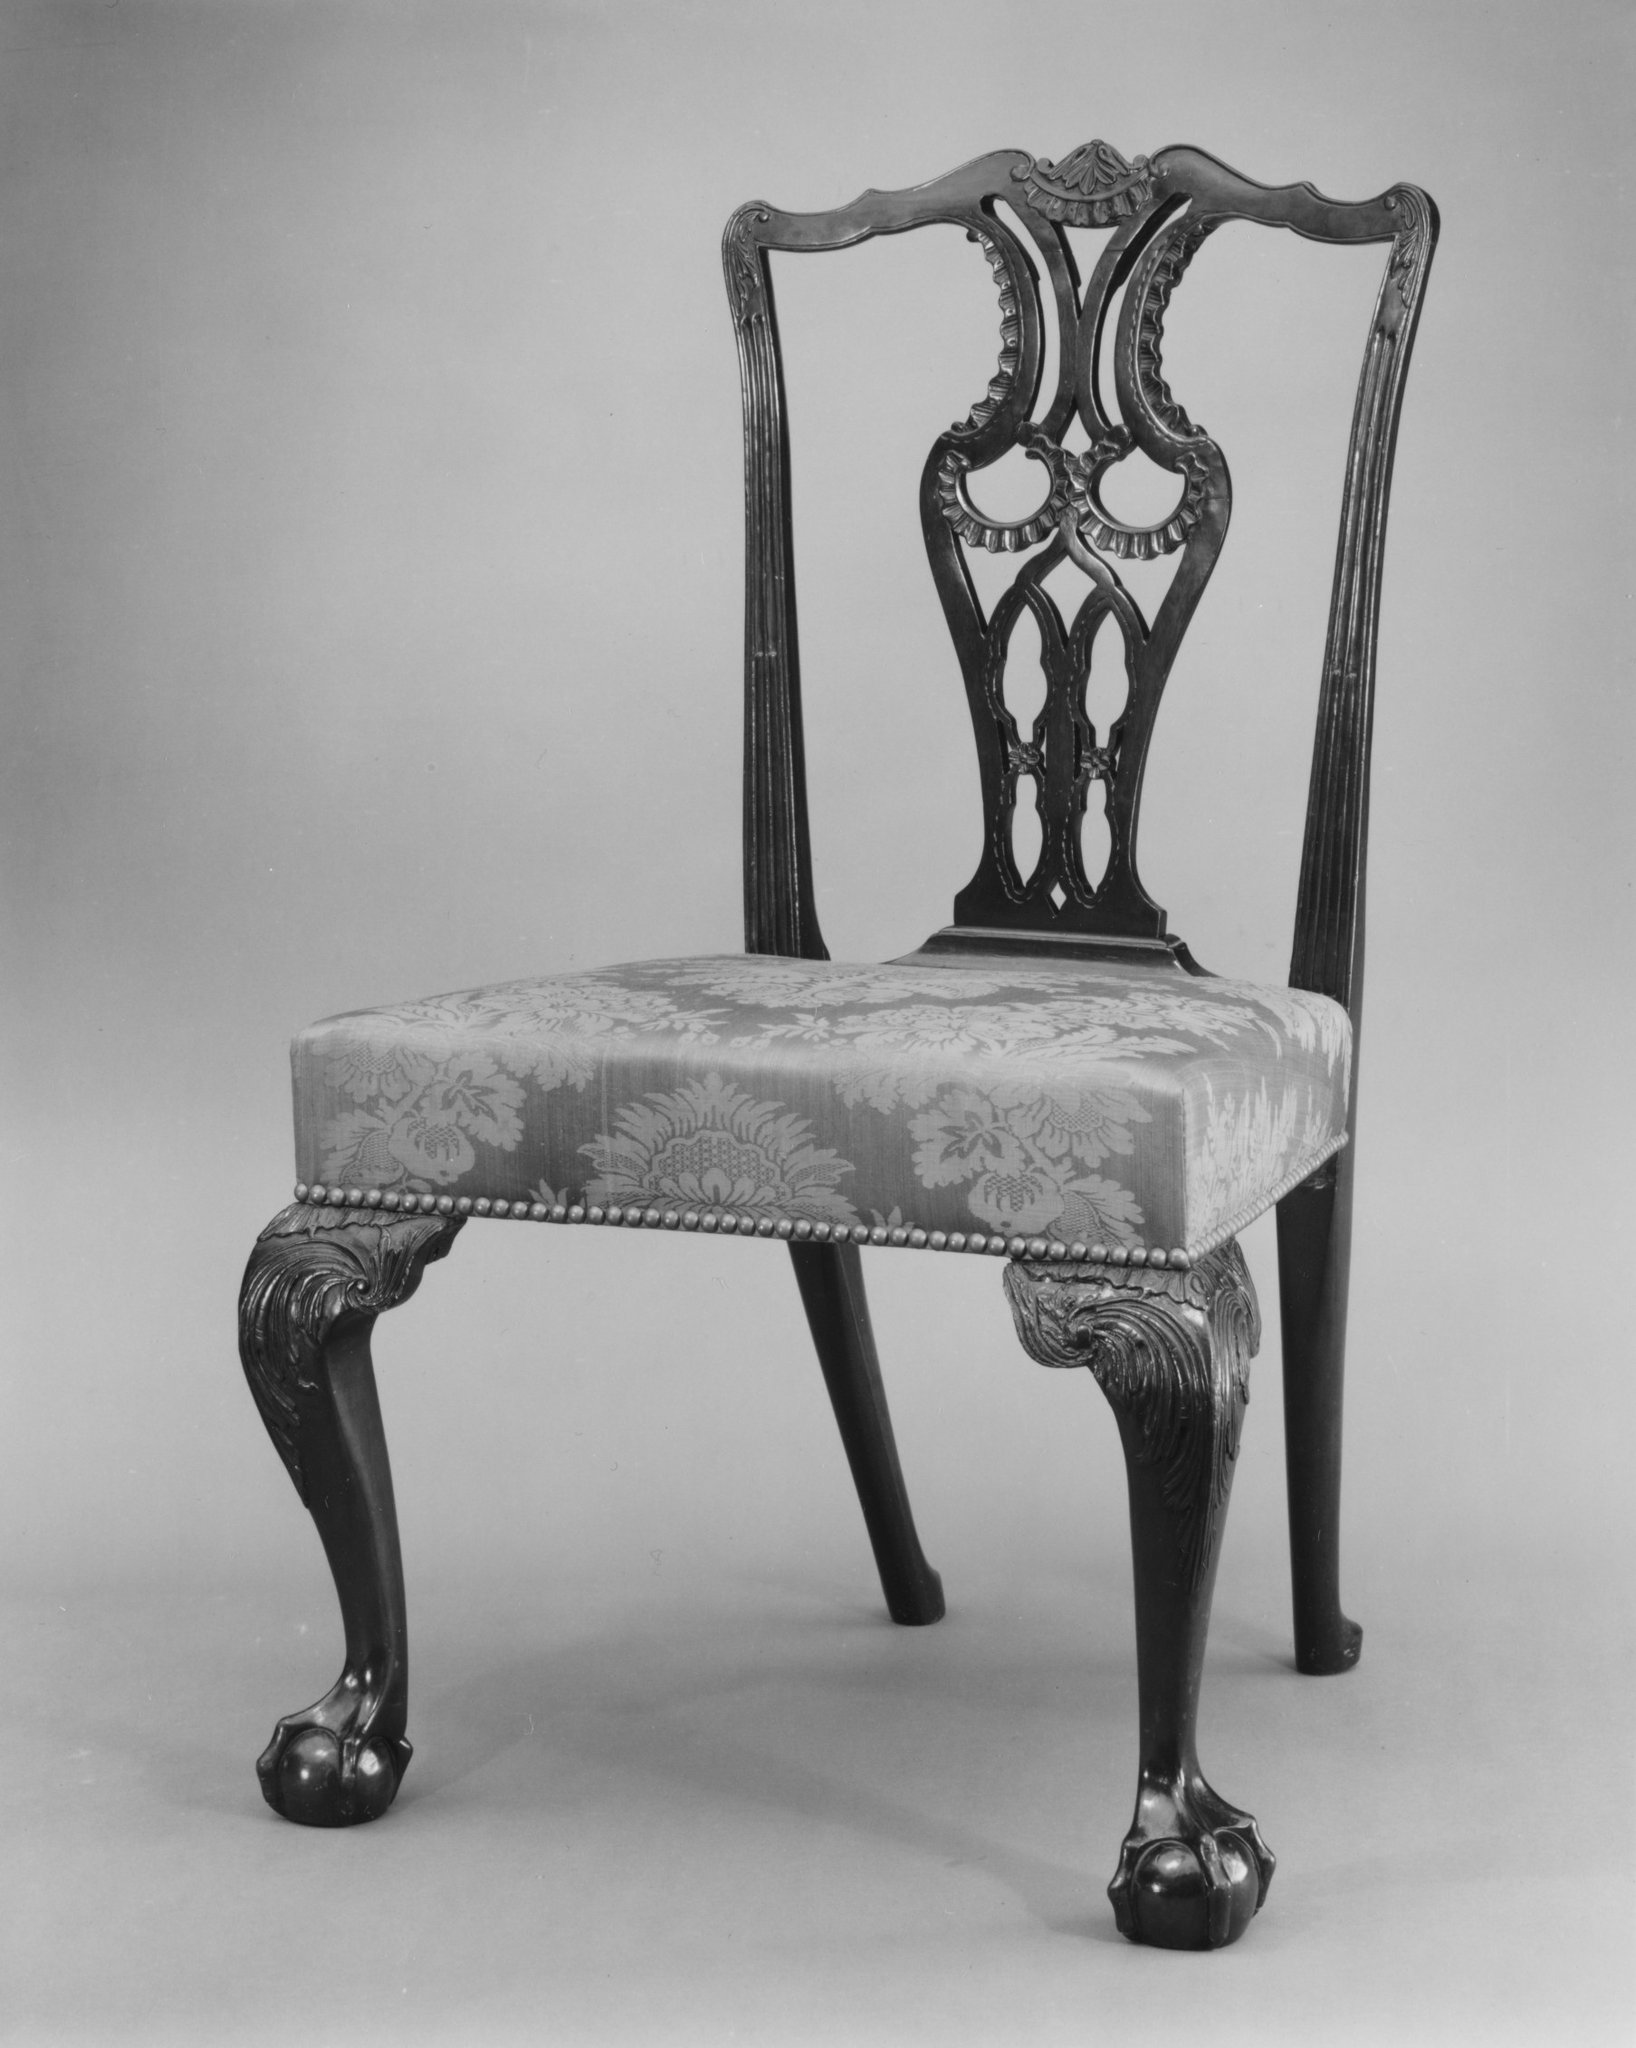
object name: side chair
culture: american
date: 1770-1790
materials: wood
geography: united states